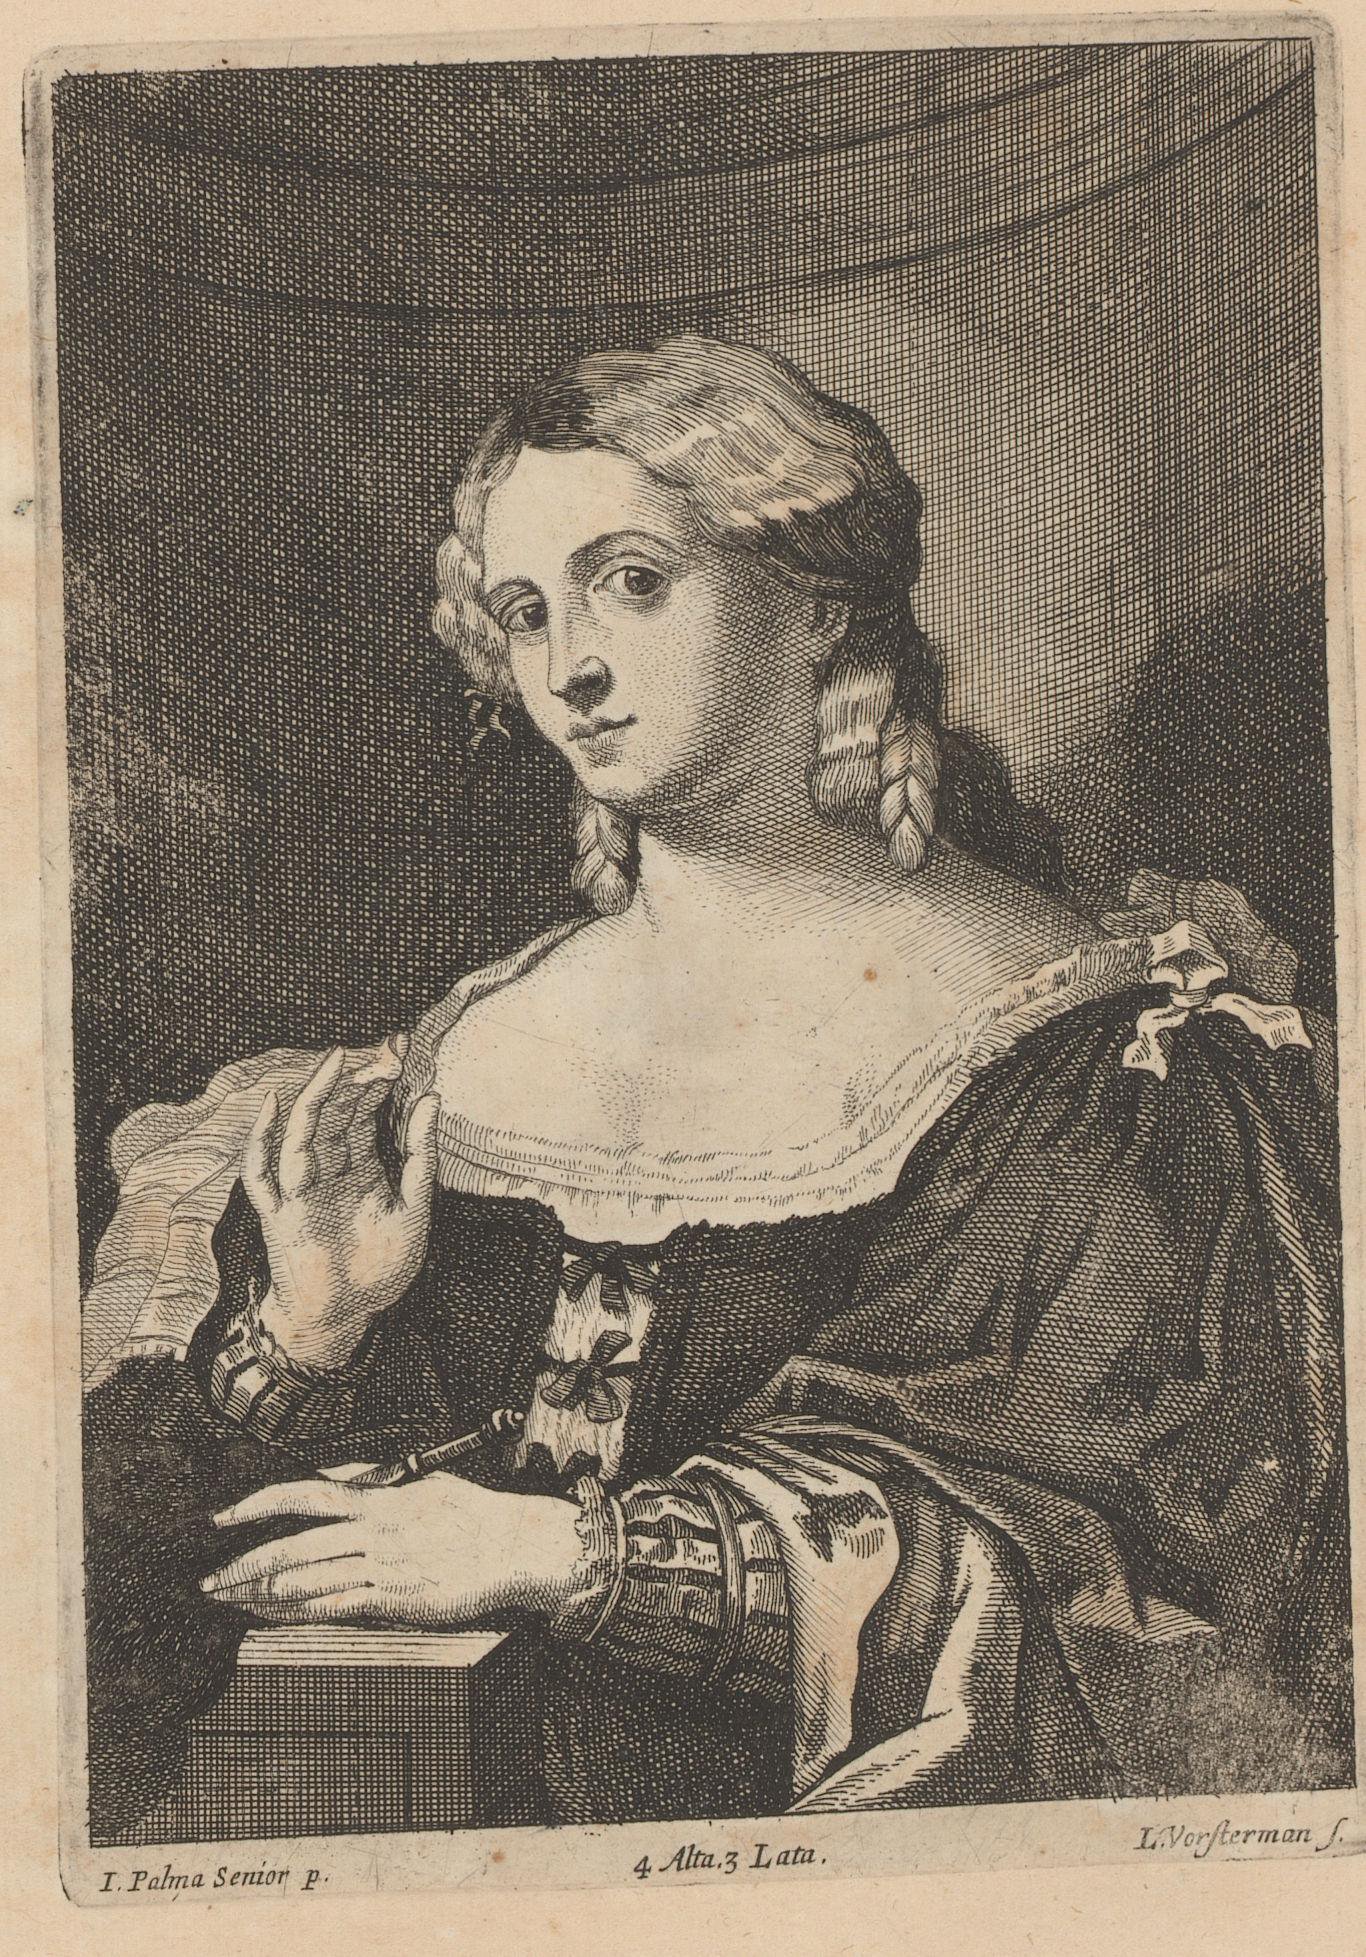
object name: album leaf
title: Portret van een onbekende vrouw met waaier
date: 1660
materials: paper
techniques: etching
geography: brussels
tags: anonymous historical person portrayed alone - bb - woman, fan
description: De prent is vervaardigd naar het schilderij van Palma dat zich in de collectie van het Kunsthistorisches Museum te Wenen bevindt (inventarisnummer GG_63). David Teniers heeft waarschijnlijk van alle schilderijen uit de collectie van Leopold Willem van Oostenrijk een olieverfstudie op doek of paneel vervaardigd (zgn. pasticcio), die als voorbeeld voor de prentmakers diende. Het is niet altijd duidelijk of de pasticci door hem zijn gemaakt of door zijn atelier. Niet alle pasticci zijn overgeleverd.